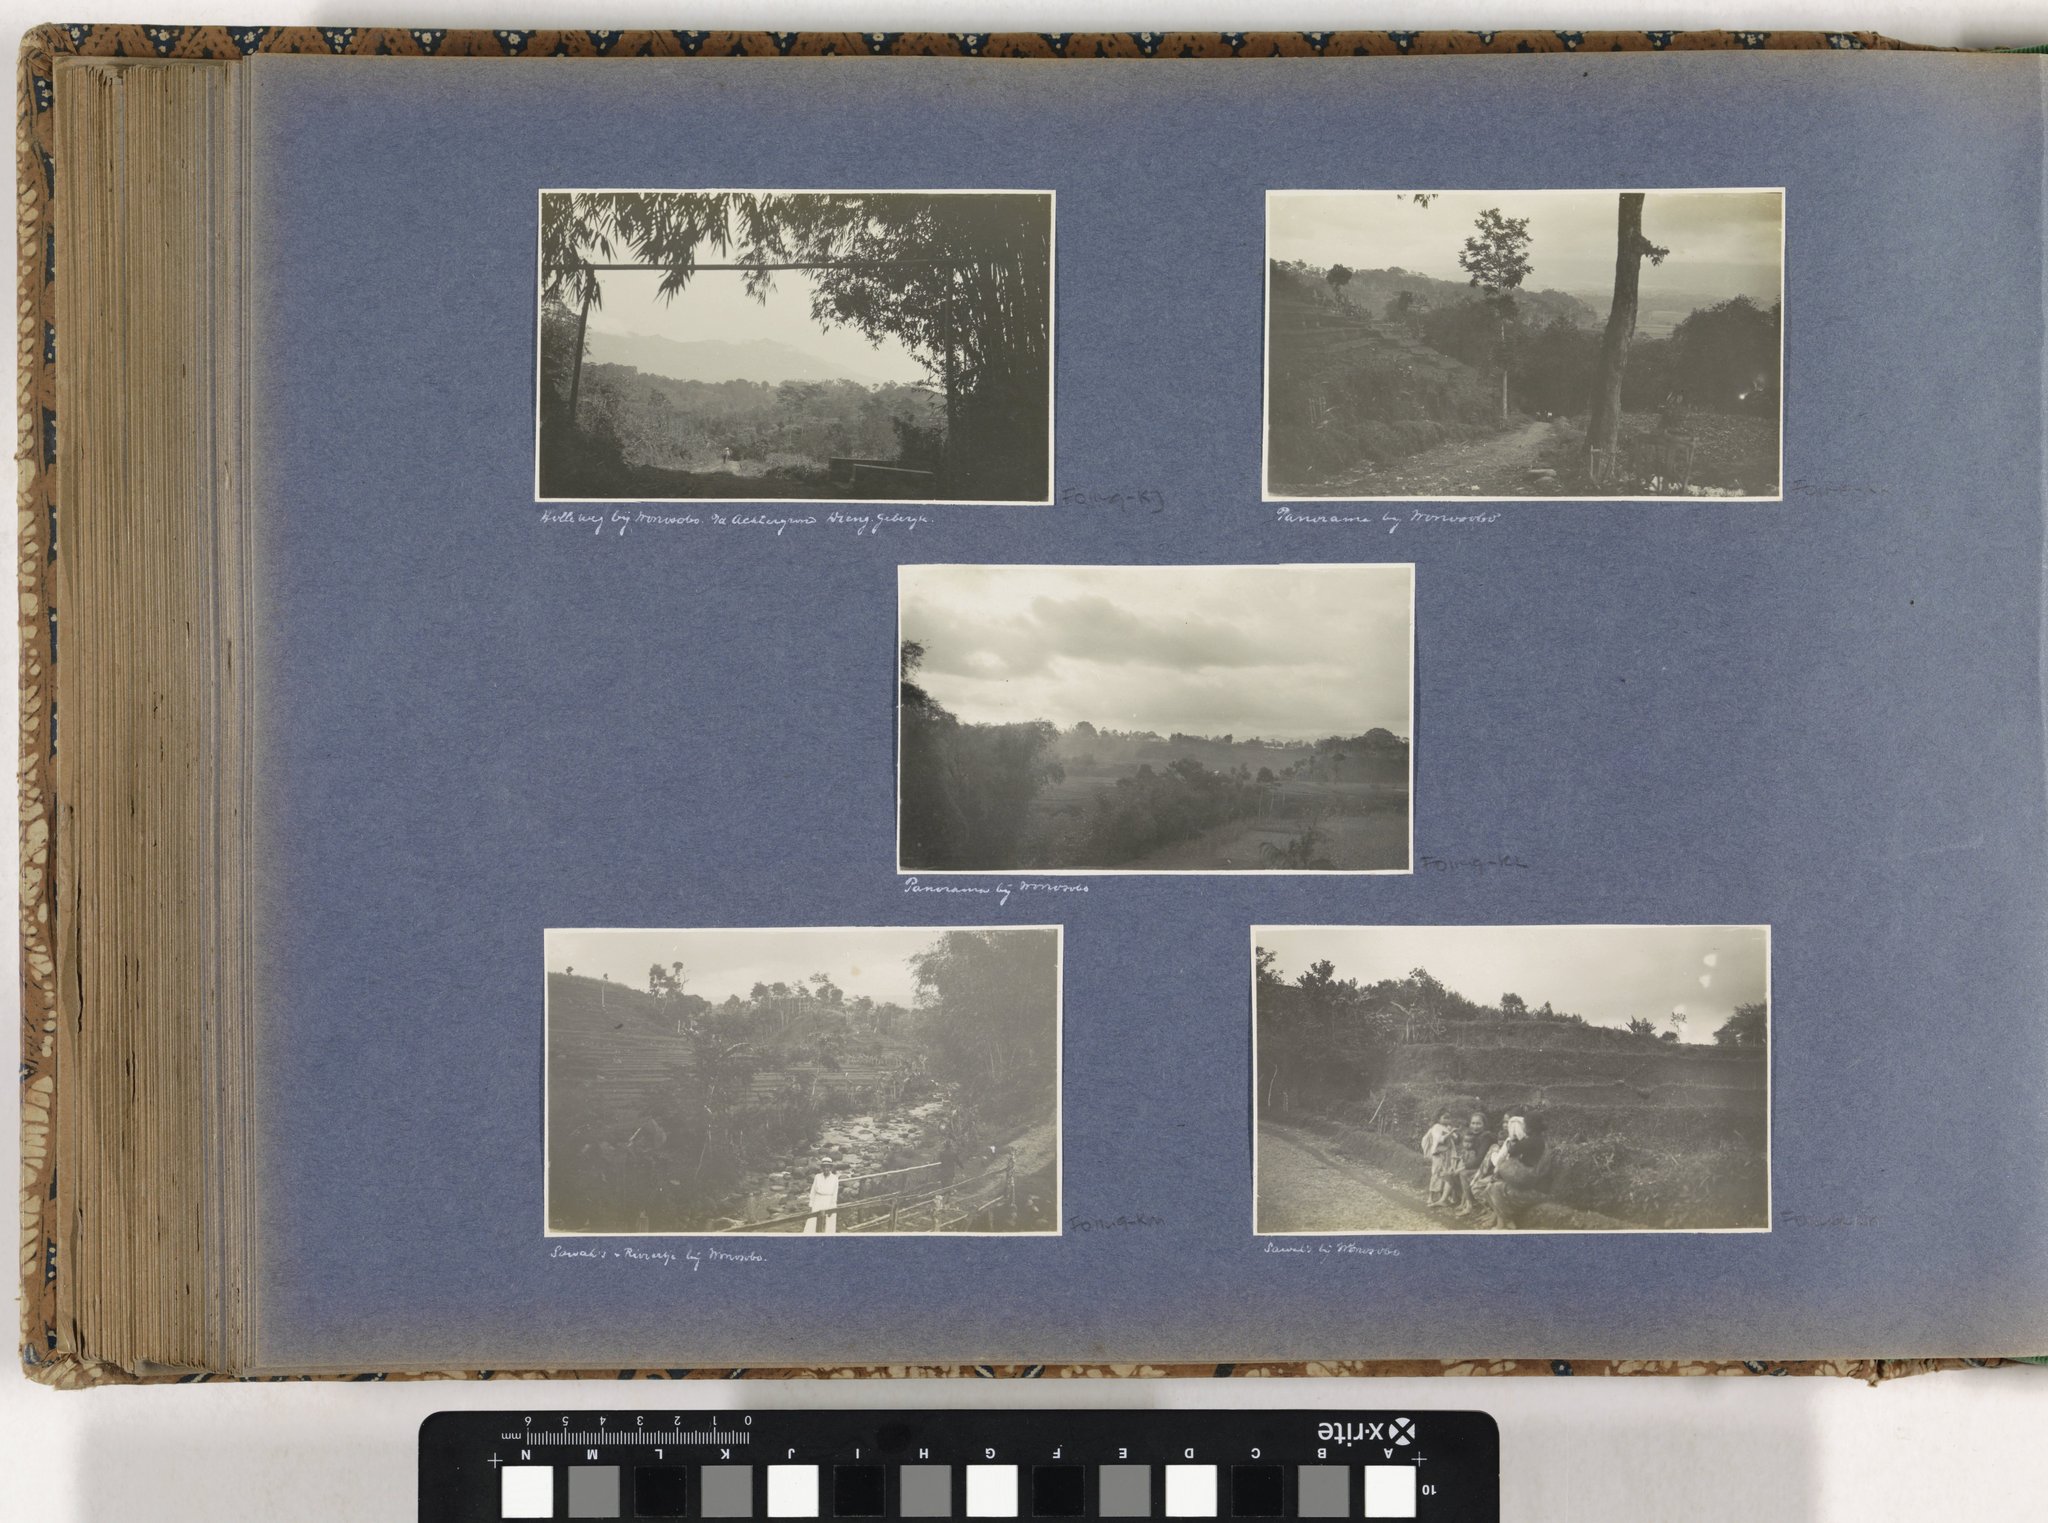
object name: photograph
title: Landschap bij Wonosobo met wolkenlucht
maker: Anonymous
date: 1900-1920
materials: paper, photographic support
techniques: gelatin silver print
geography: java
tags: clouds, mountains (in tropical and sub-tropical regions), java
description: Onderdeel van reisalbum met foto's van bedrijvigheid en bezienswaardigheden op Sumatra en Java en van de reis naar en van Nederlands-Indië.